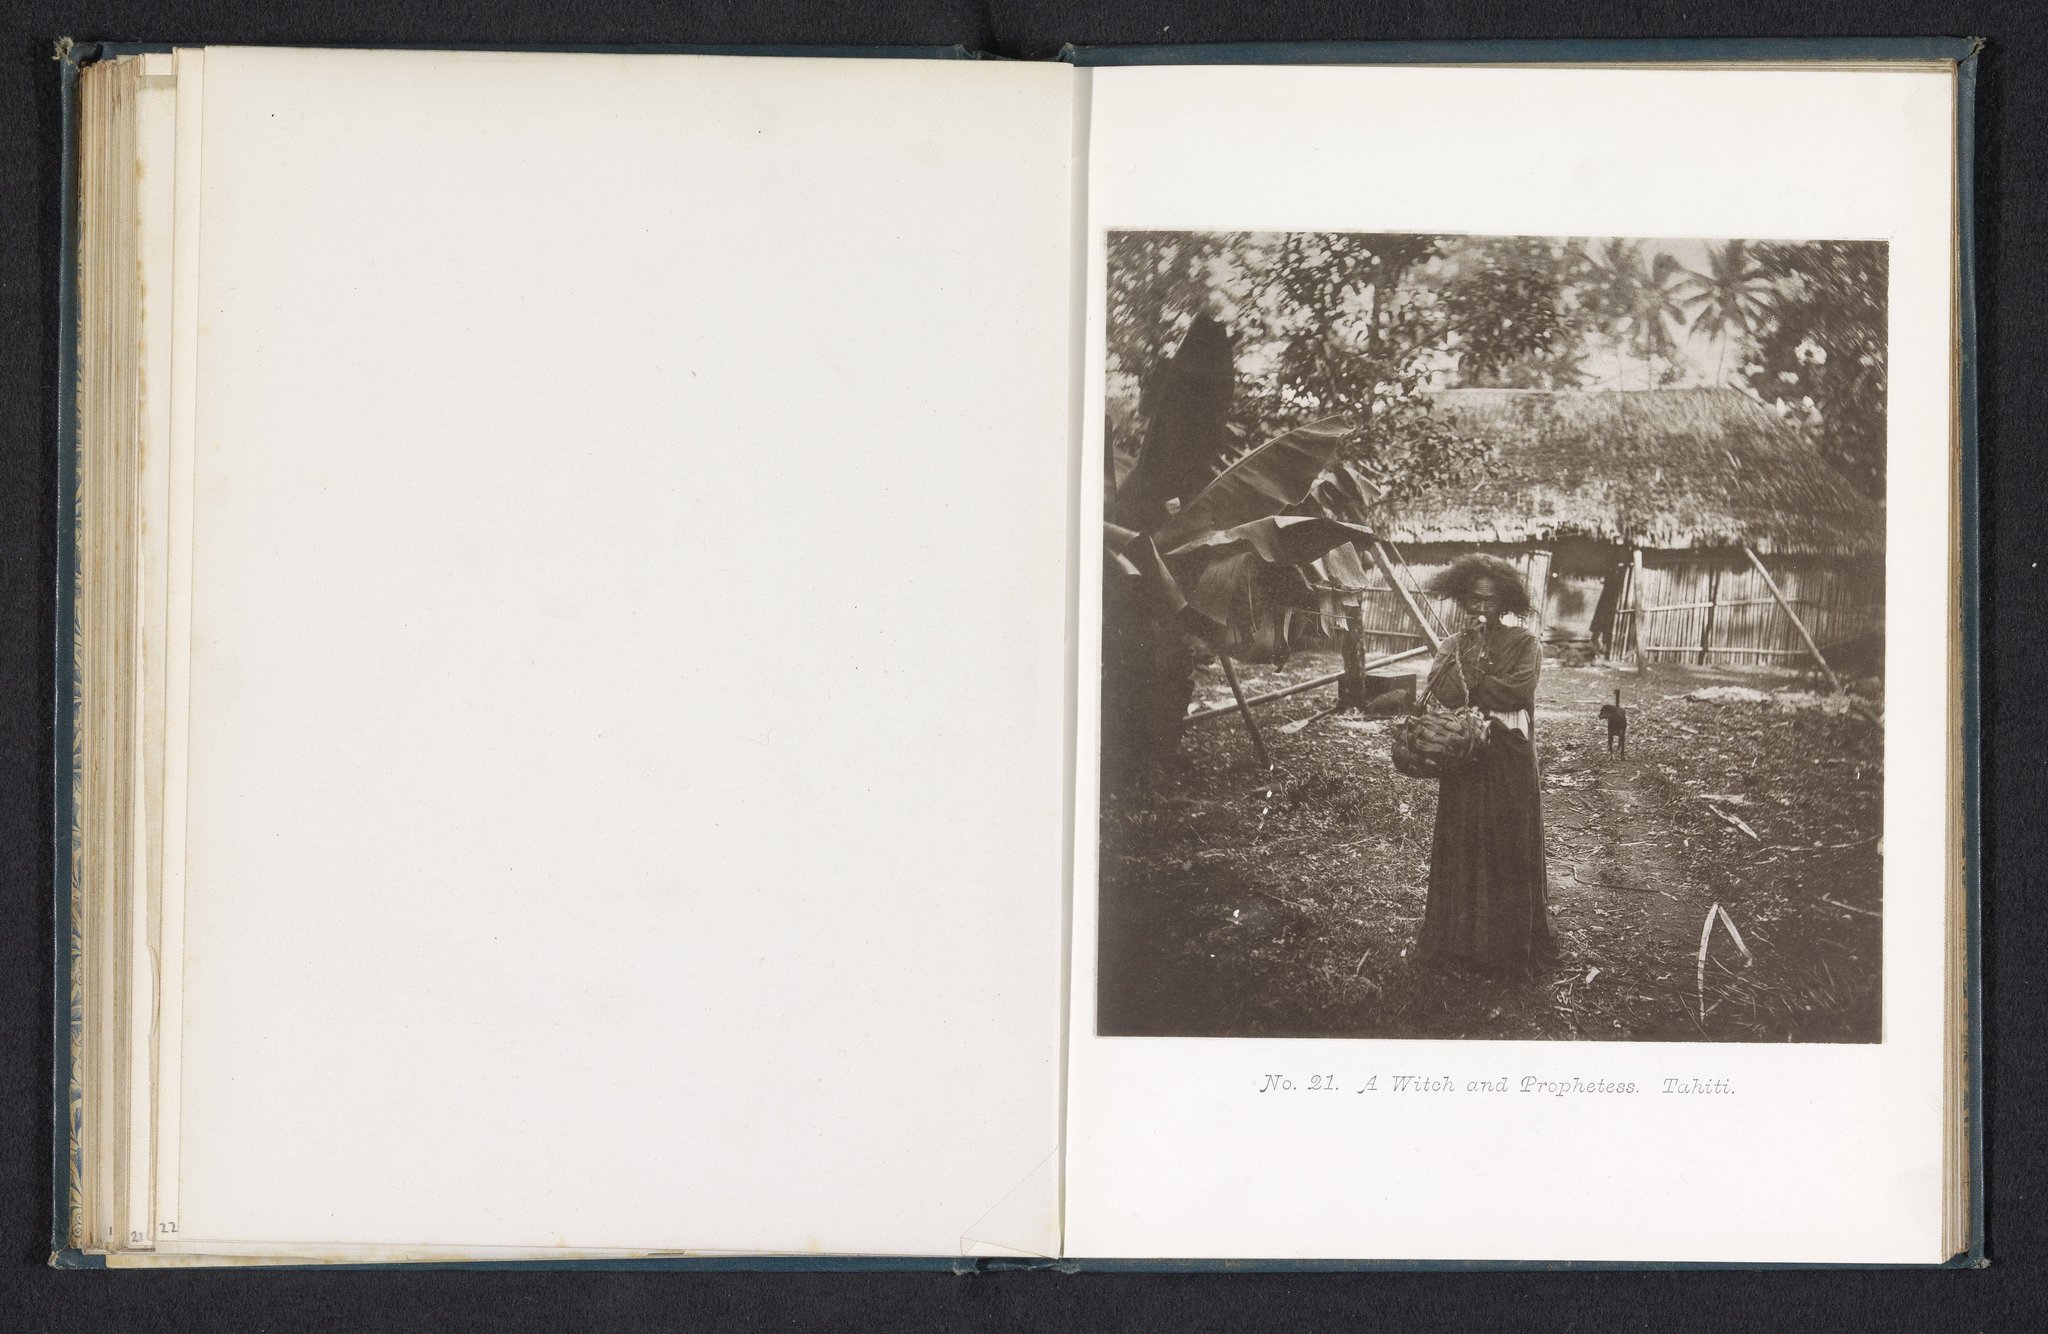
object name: page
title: Portret van een onbekende vrouw voor een woning in Tahiti, mogelijk heeft zij magische of profetische gaven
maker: henry stuart-wortley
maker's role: fotograaf, kolonel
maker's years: 1832-1890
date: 1880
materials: paper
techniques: photograph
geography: tahiti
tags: witch, sorceress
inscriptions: number: ‘No. 21.’